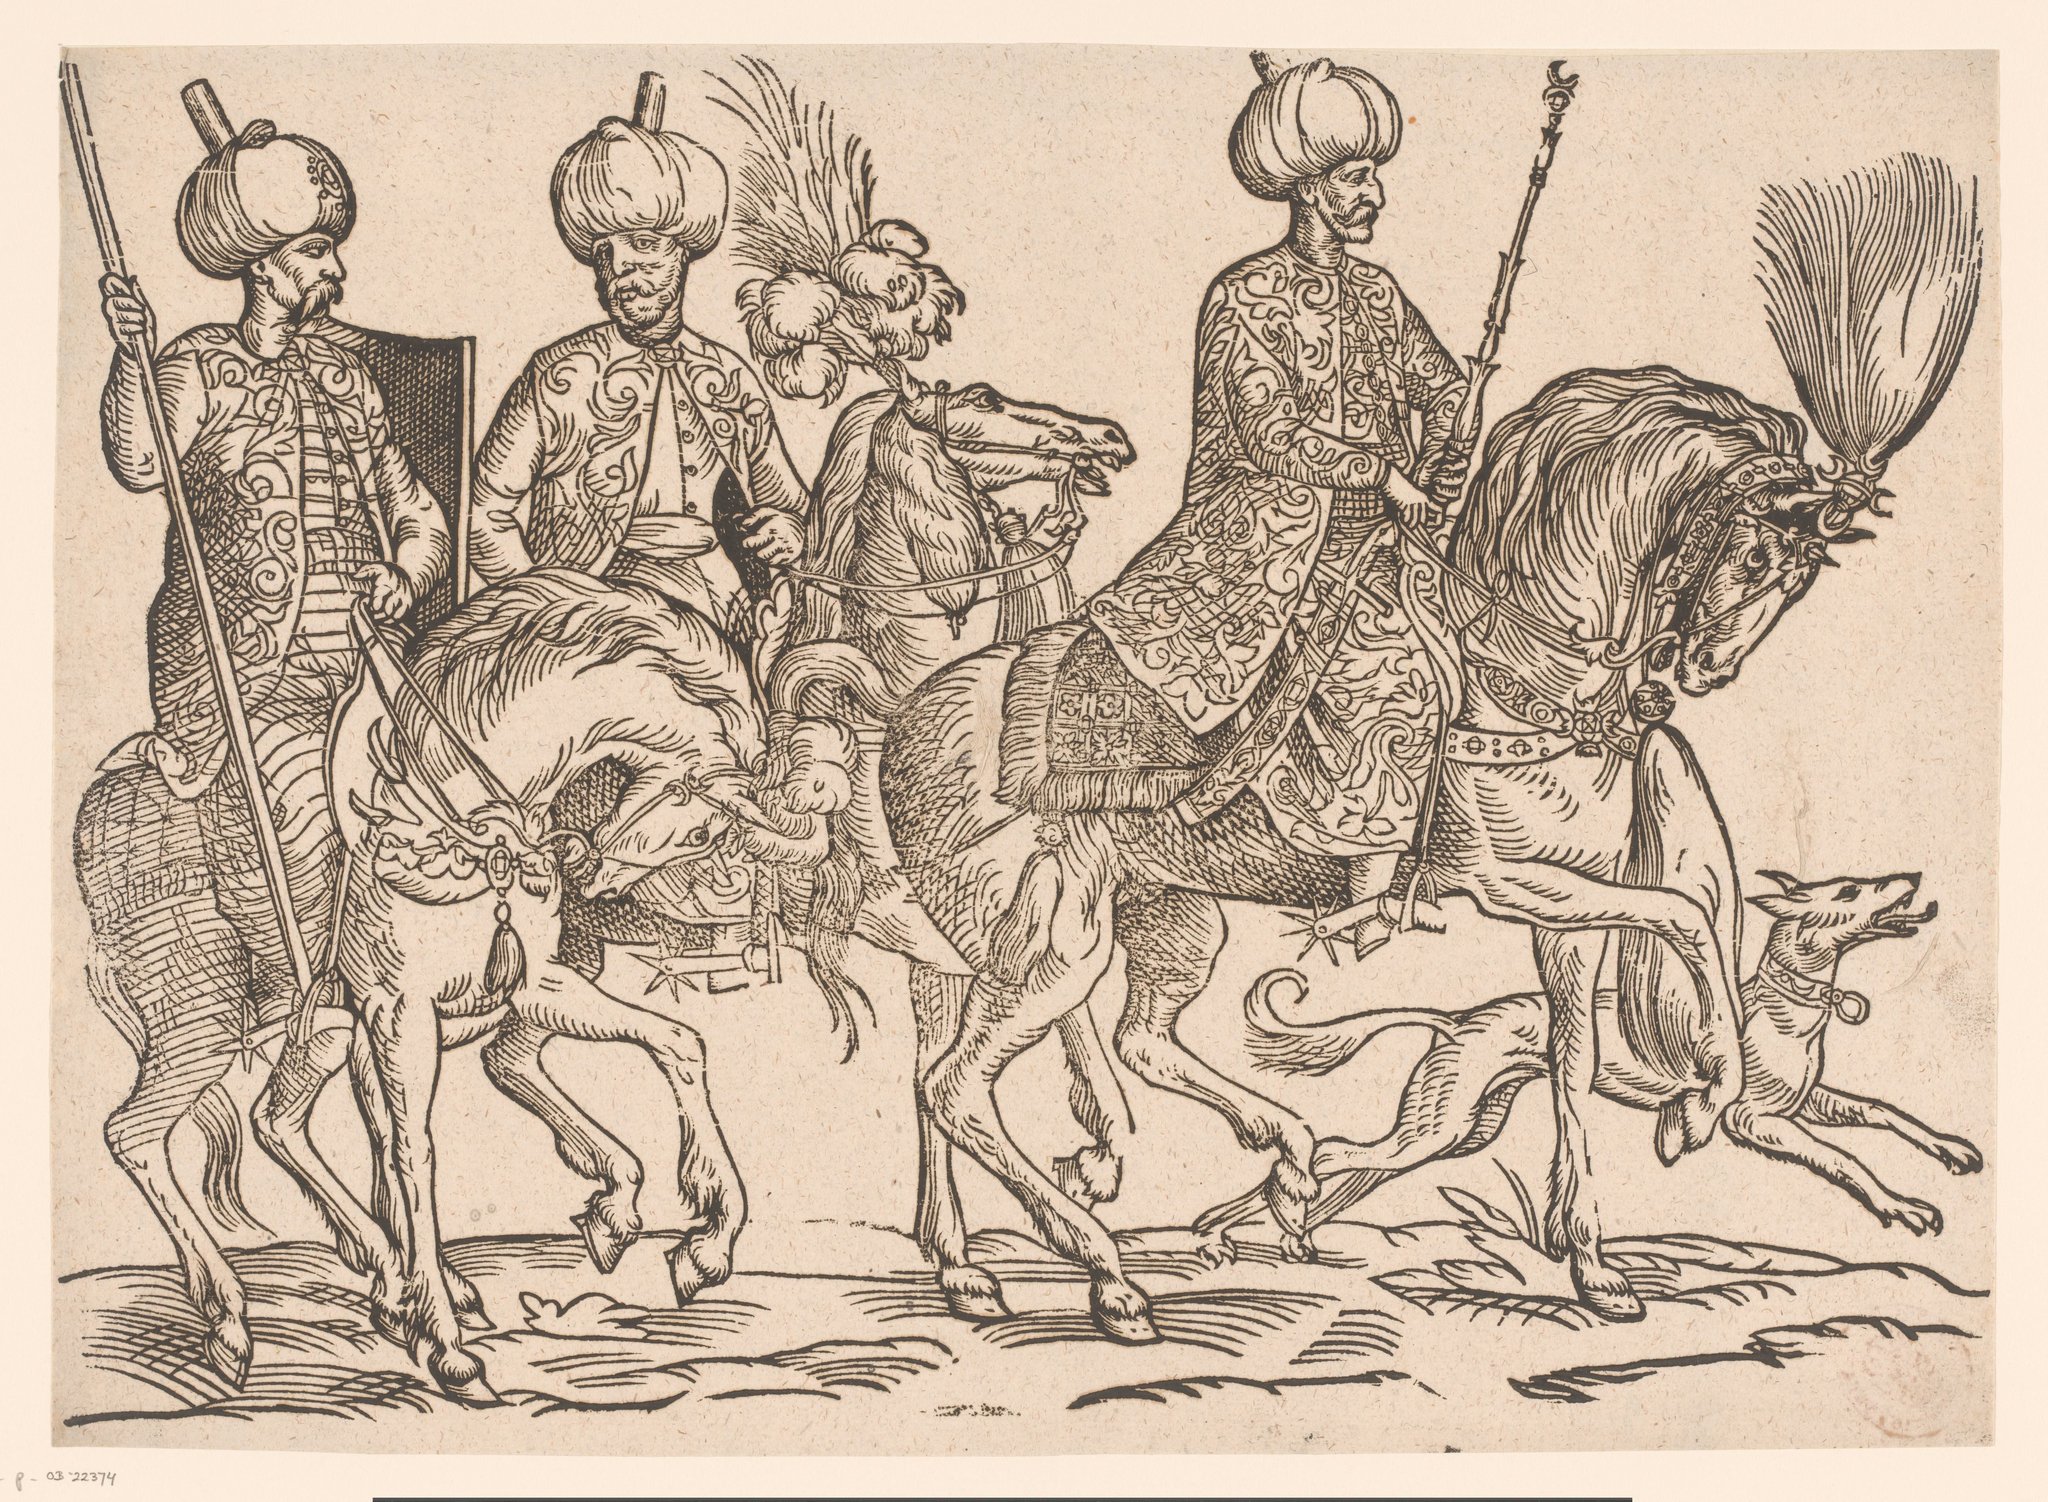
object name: print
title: Drie Turkse ruiters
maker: Anonymous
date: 1500-1599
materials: paper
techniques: woodcut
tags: riding a horse, ass, or mule; rider, horseman, asiatic races and peoples: turks, the soldier; the soldier's life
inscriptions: collector's mark: Lugt 240